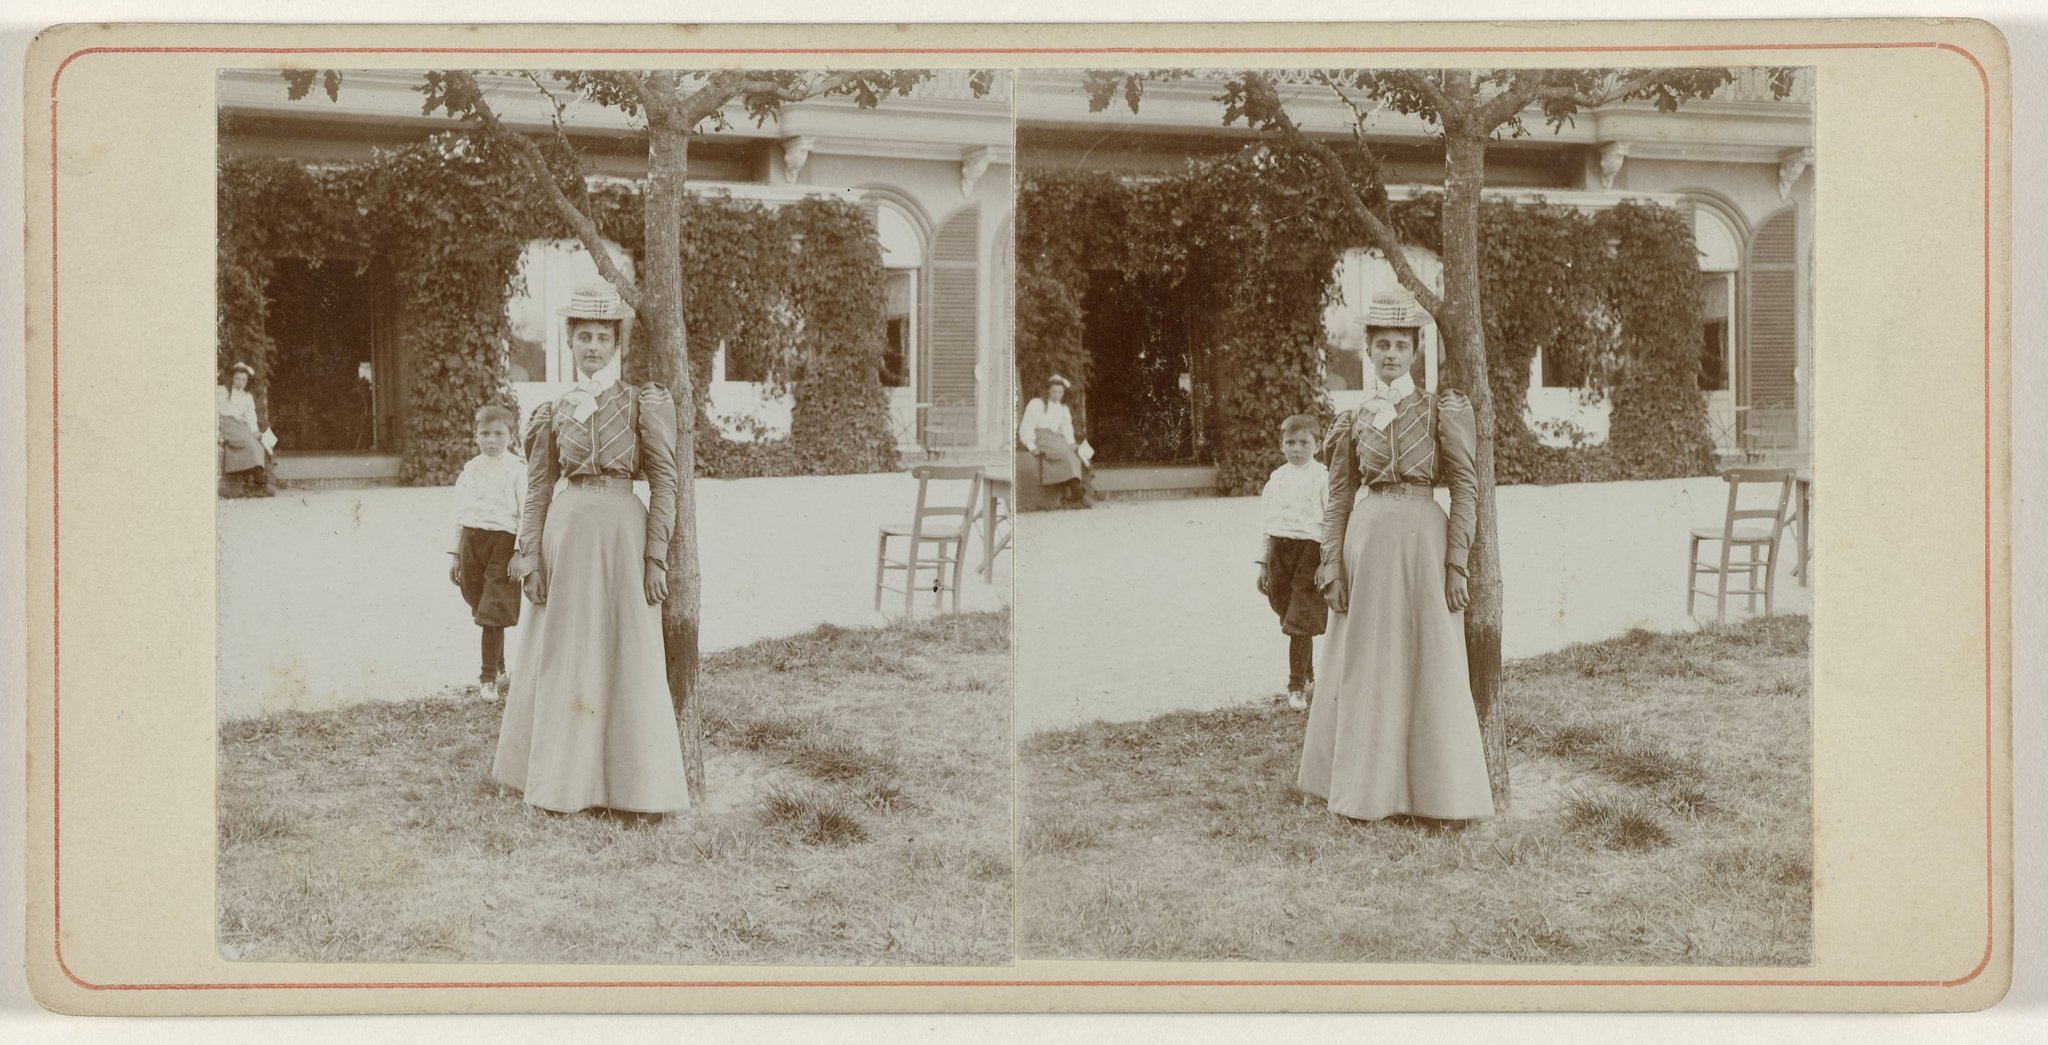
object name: stereograph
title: Portret van een vrouw onder een boom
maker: geldolph adriaan kessler (dolph)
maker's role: fotograaf, industrieel, voetballer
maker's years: 1884-1945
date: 1899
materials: cardboard, paper, photographic support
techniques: collodion silver print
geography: netherlands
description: De vrouw poseert voor een woning, schuin achter de vrouw staat een jongetje in een pofbroek.